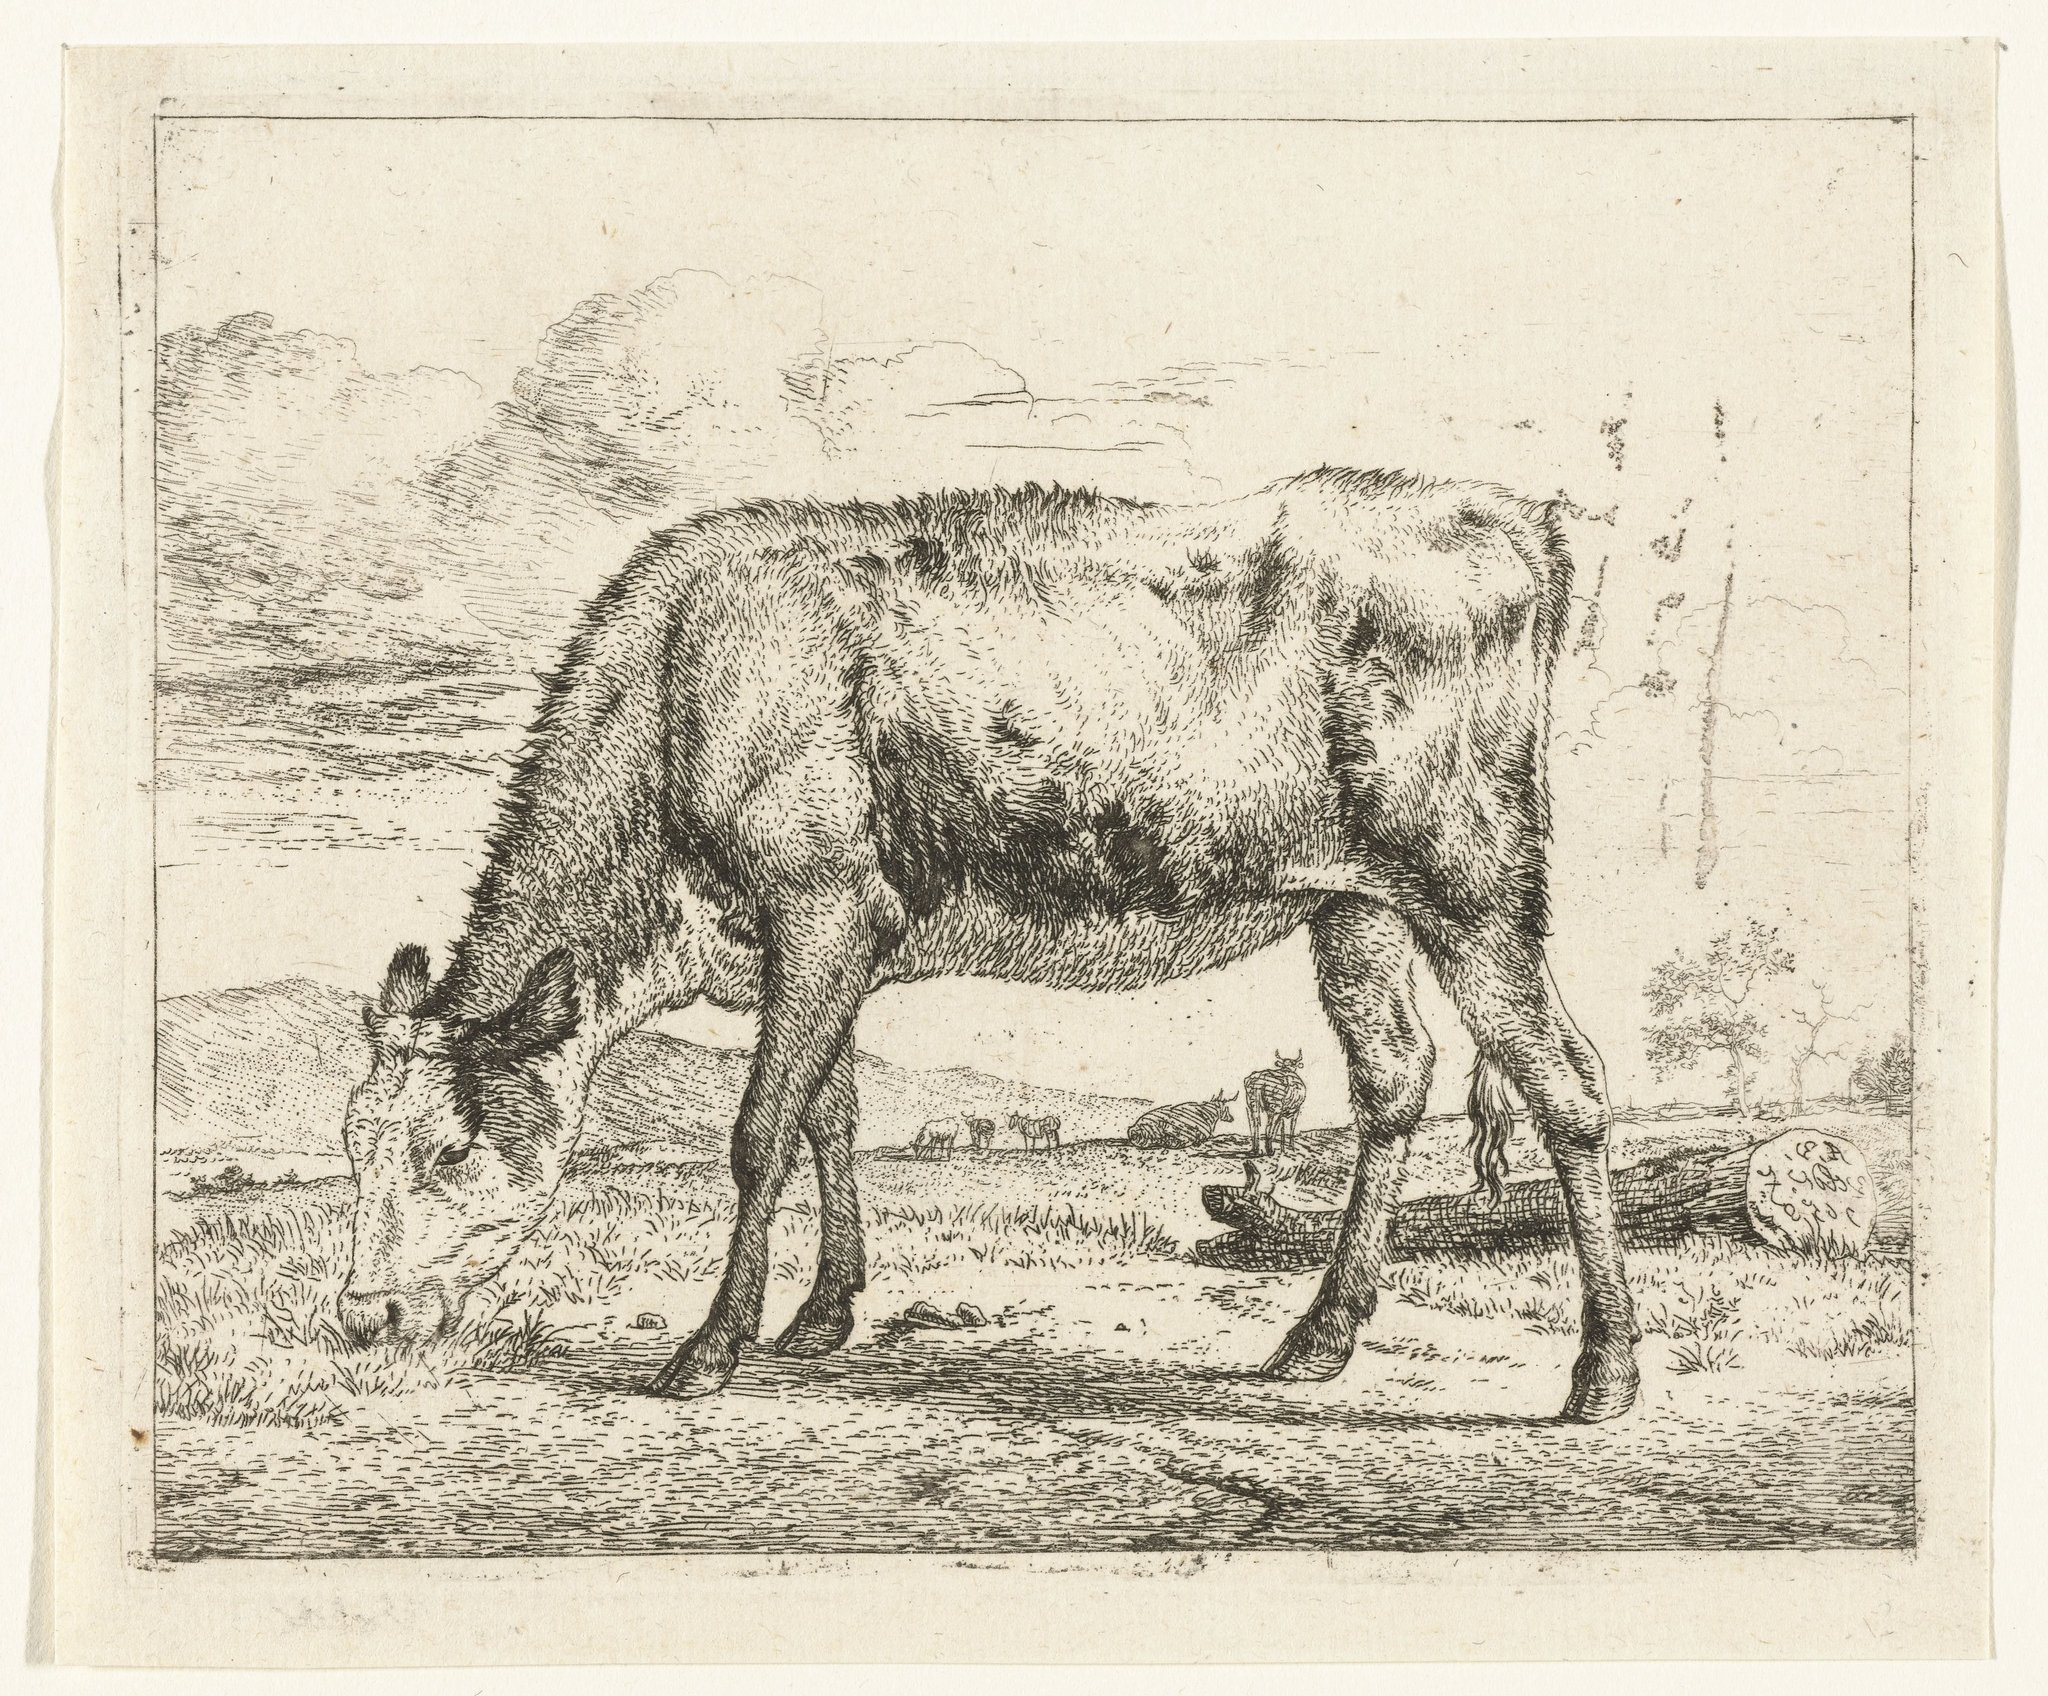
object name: print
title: Verschillende dieren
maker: adriaen van de velde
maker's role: draughtsman, painter, print maker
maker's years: 1636-1672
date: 1658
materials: paper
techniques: etching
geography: amsterdam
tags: calf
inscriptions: collector's mark: Lugt 240